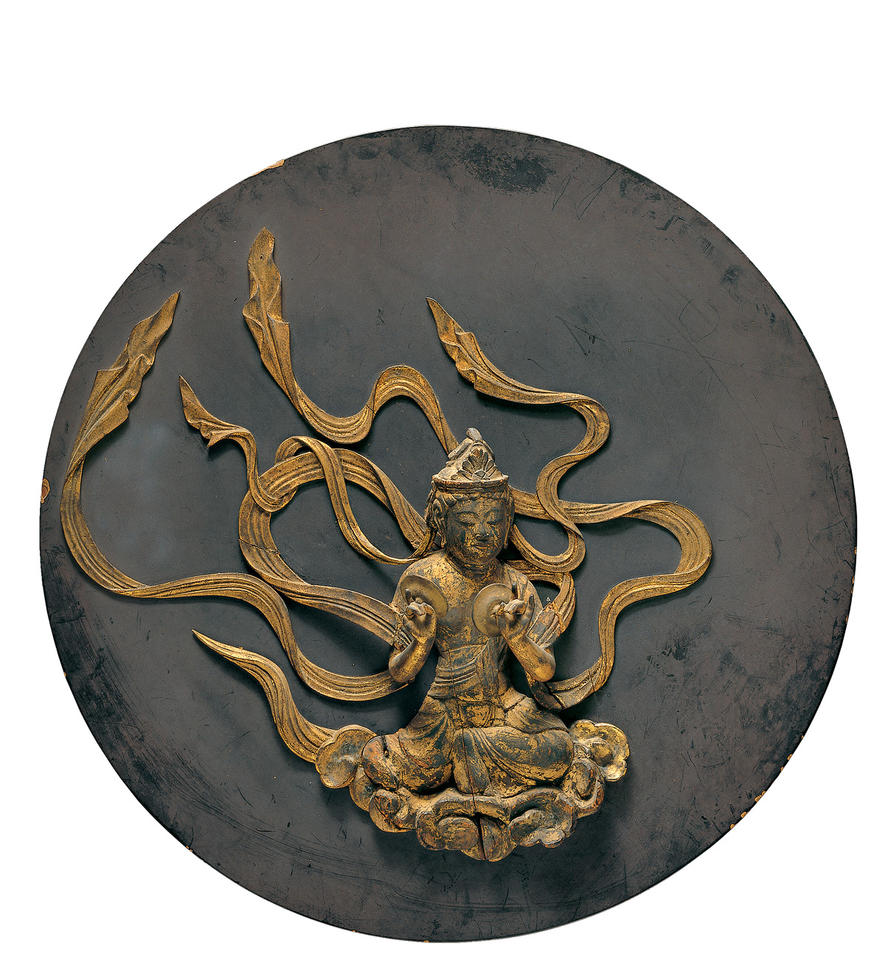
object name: plaque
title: Flying Apsaras (Hiten)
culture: japanese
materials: wood, gold, lacquer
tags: buddhism,bodhisattvas